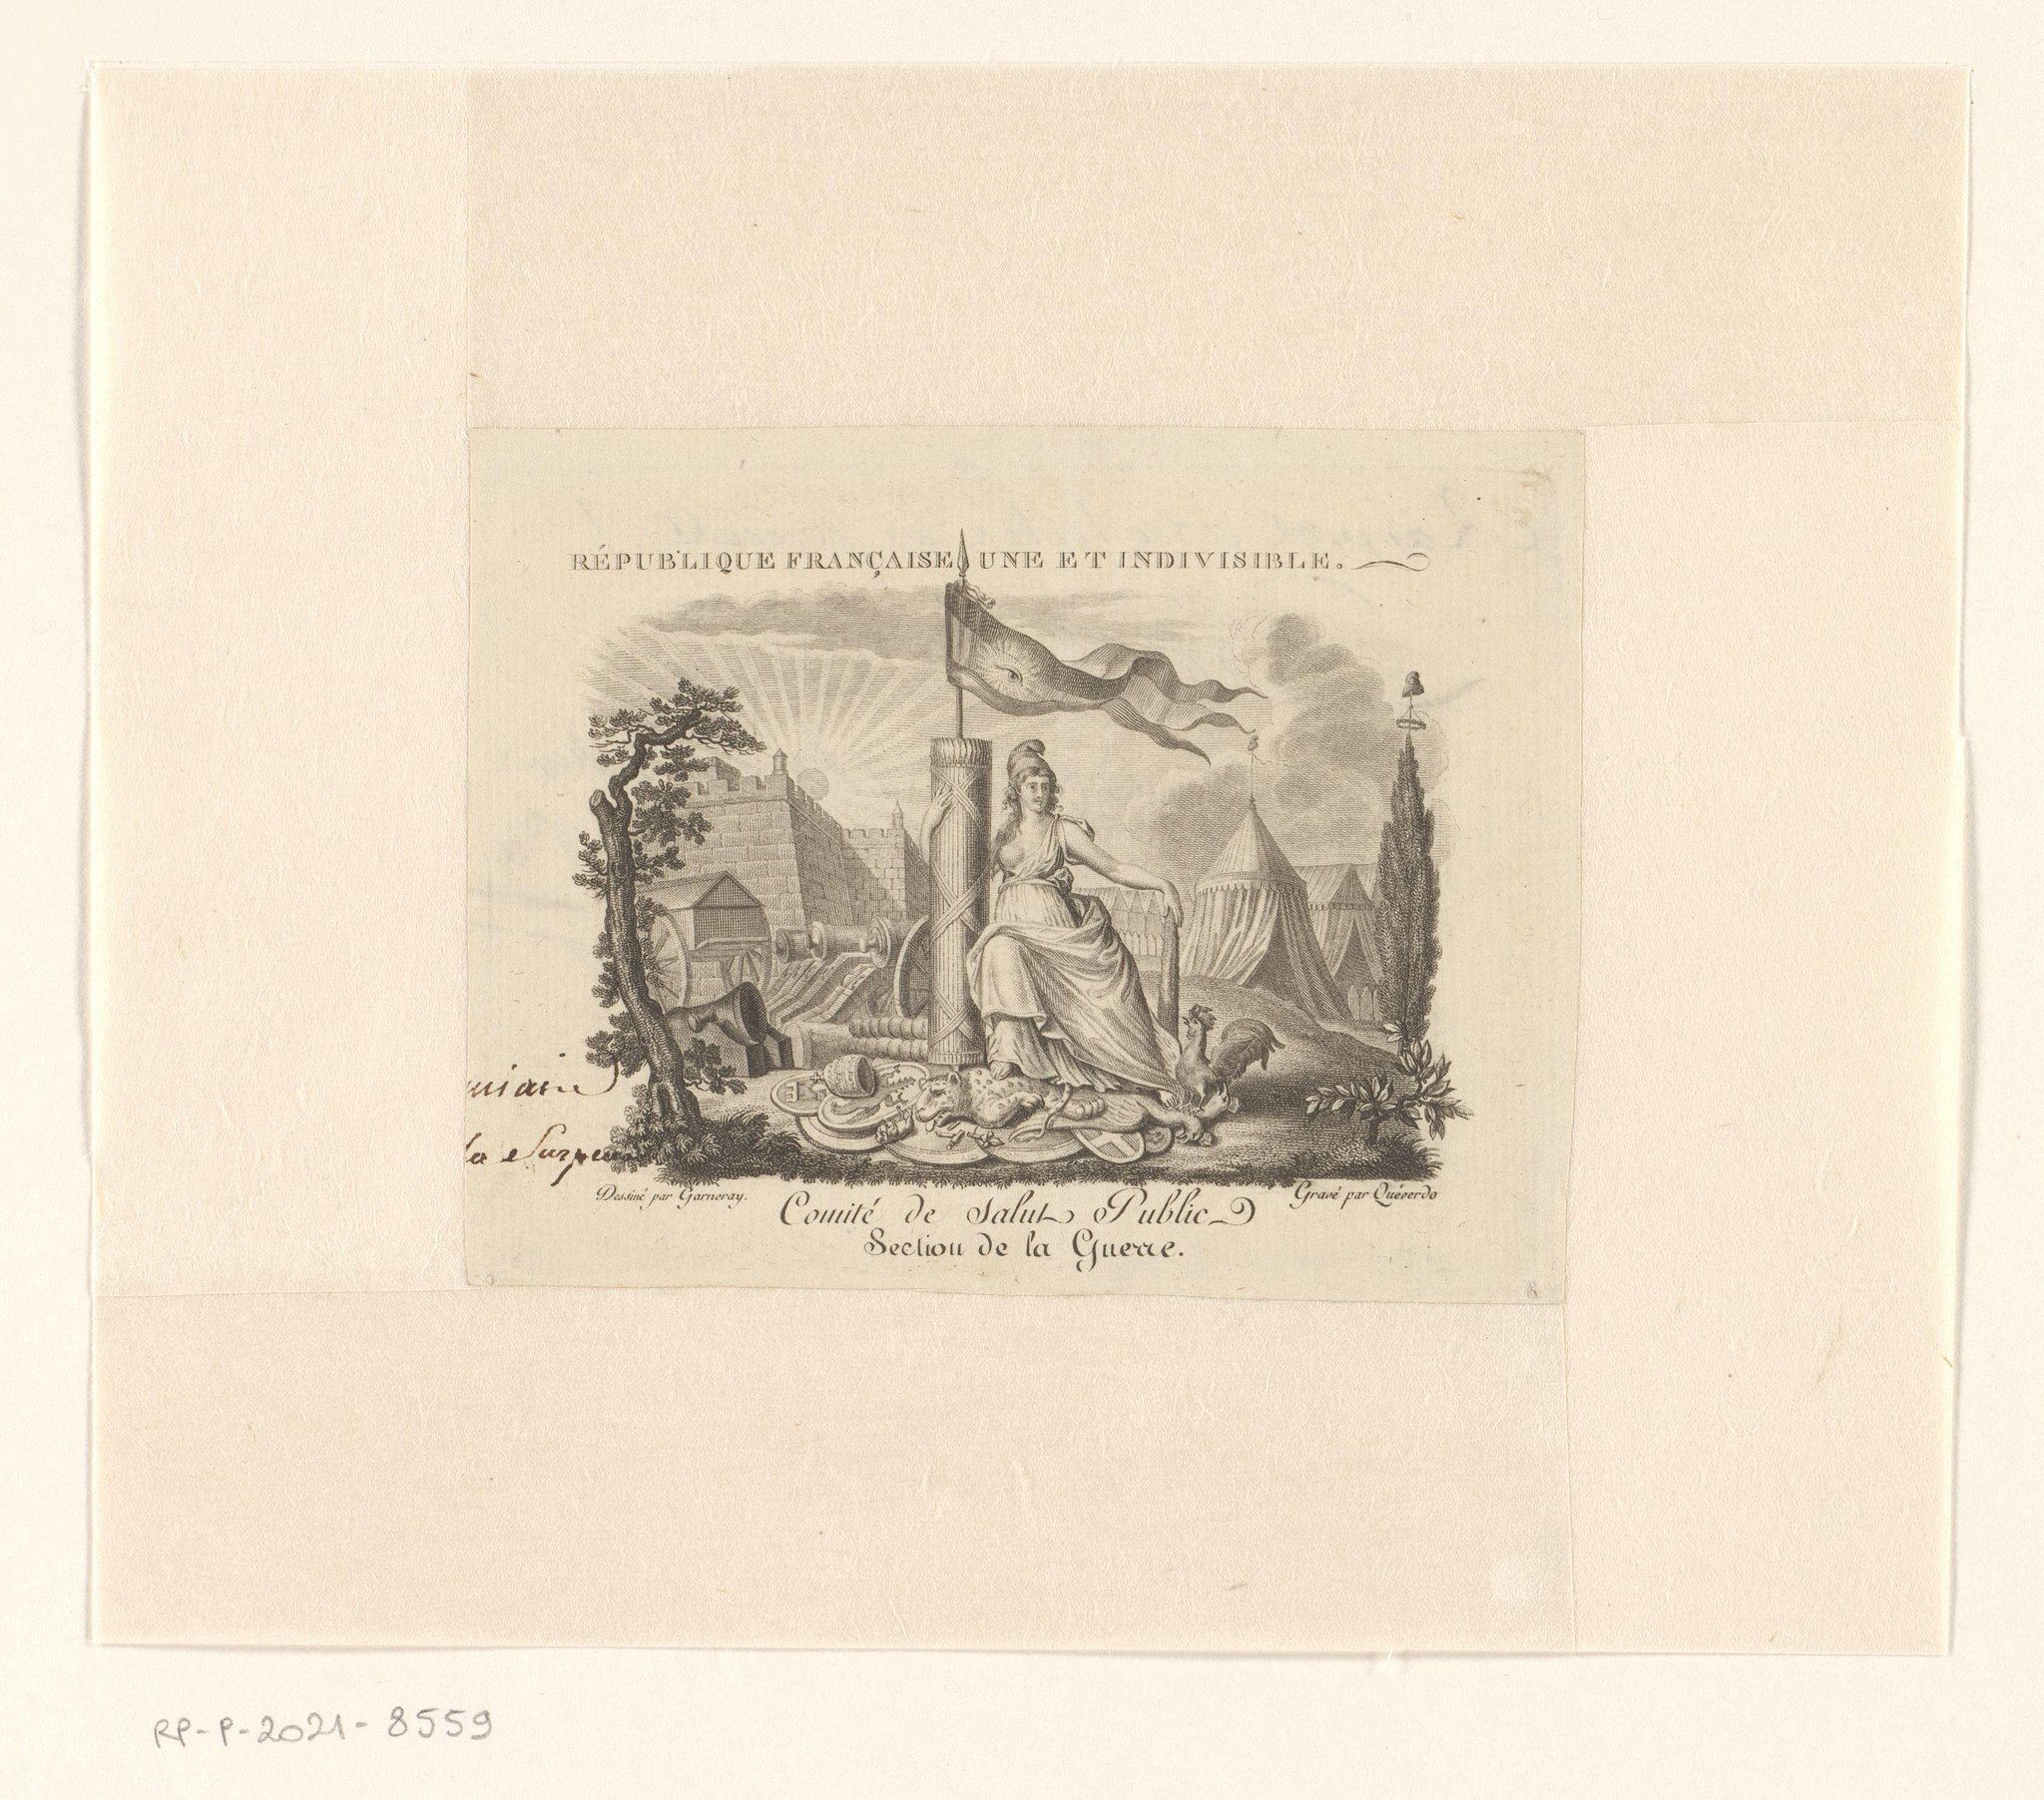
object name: print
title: Personificatie van Frankrijk (Marianne) voor een legerkamp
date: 1793-1795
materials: paper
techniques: etching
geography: france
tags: politician, (military) camp with tents, personifications of countries, nations, states, districts, etc.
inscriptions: inscription: ‘Rapport avec toutes les pieces/ Les Membres du Comité/ Merlin (d.d.)/ Charles Cochon/ j.f.B. Delmas/ Thuriot/ P.a./ [Menthau?]’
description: Onder de prent: Comité de Salut Public, Section de la Guerre. Onder Marianne liggen verschillende wapenschilden en een pauselijke kroon. Boven haar wappert de tricolore.